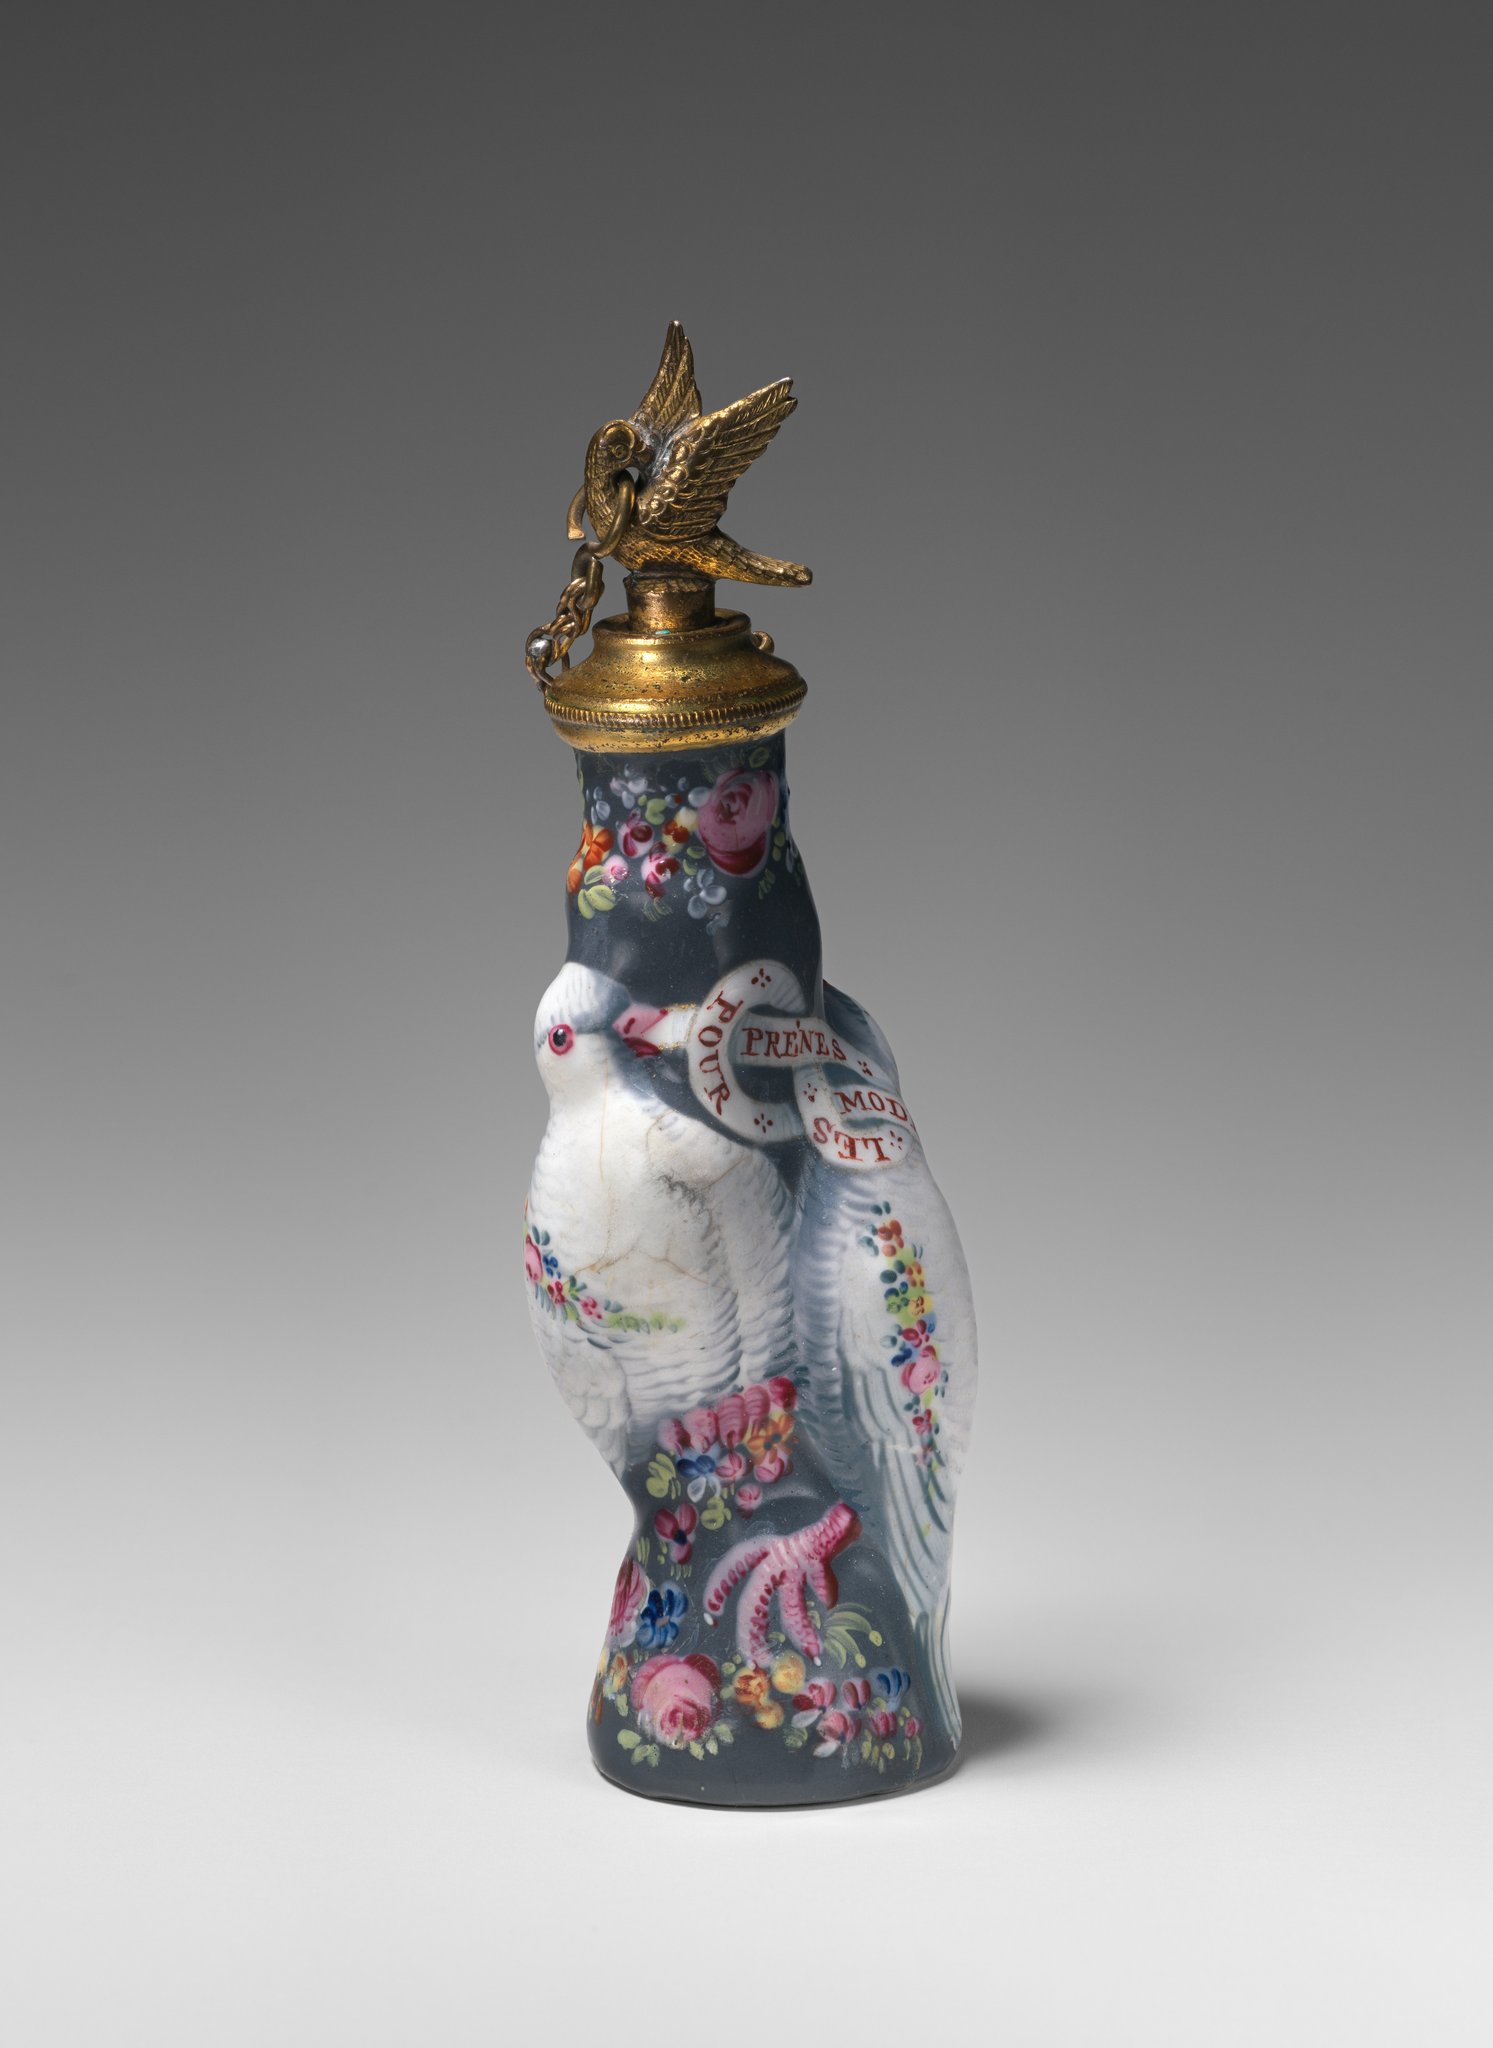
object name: scent bottle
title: Scent bottle with two doves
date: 1765-1770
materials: copper, enamel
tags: birds